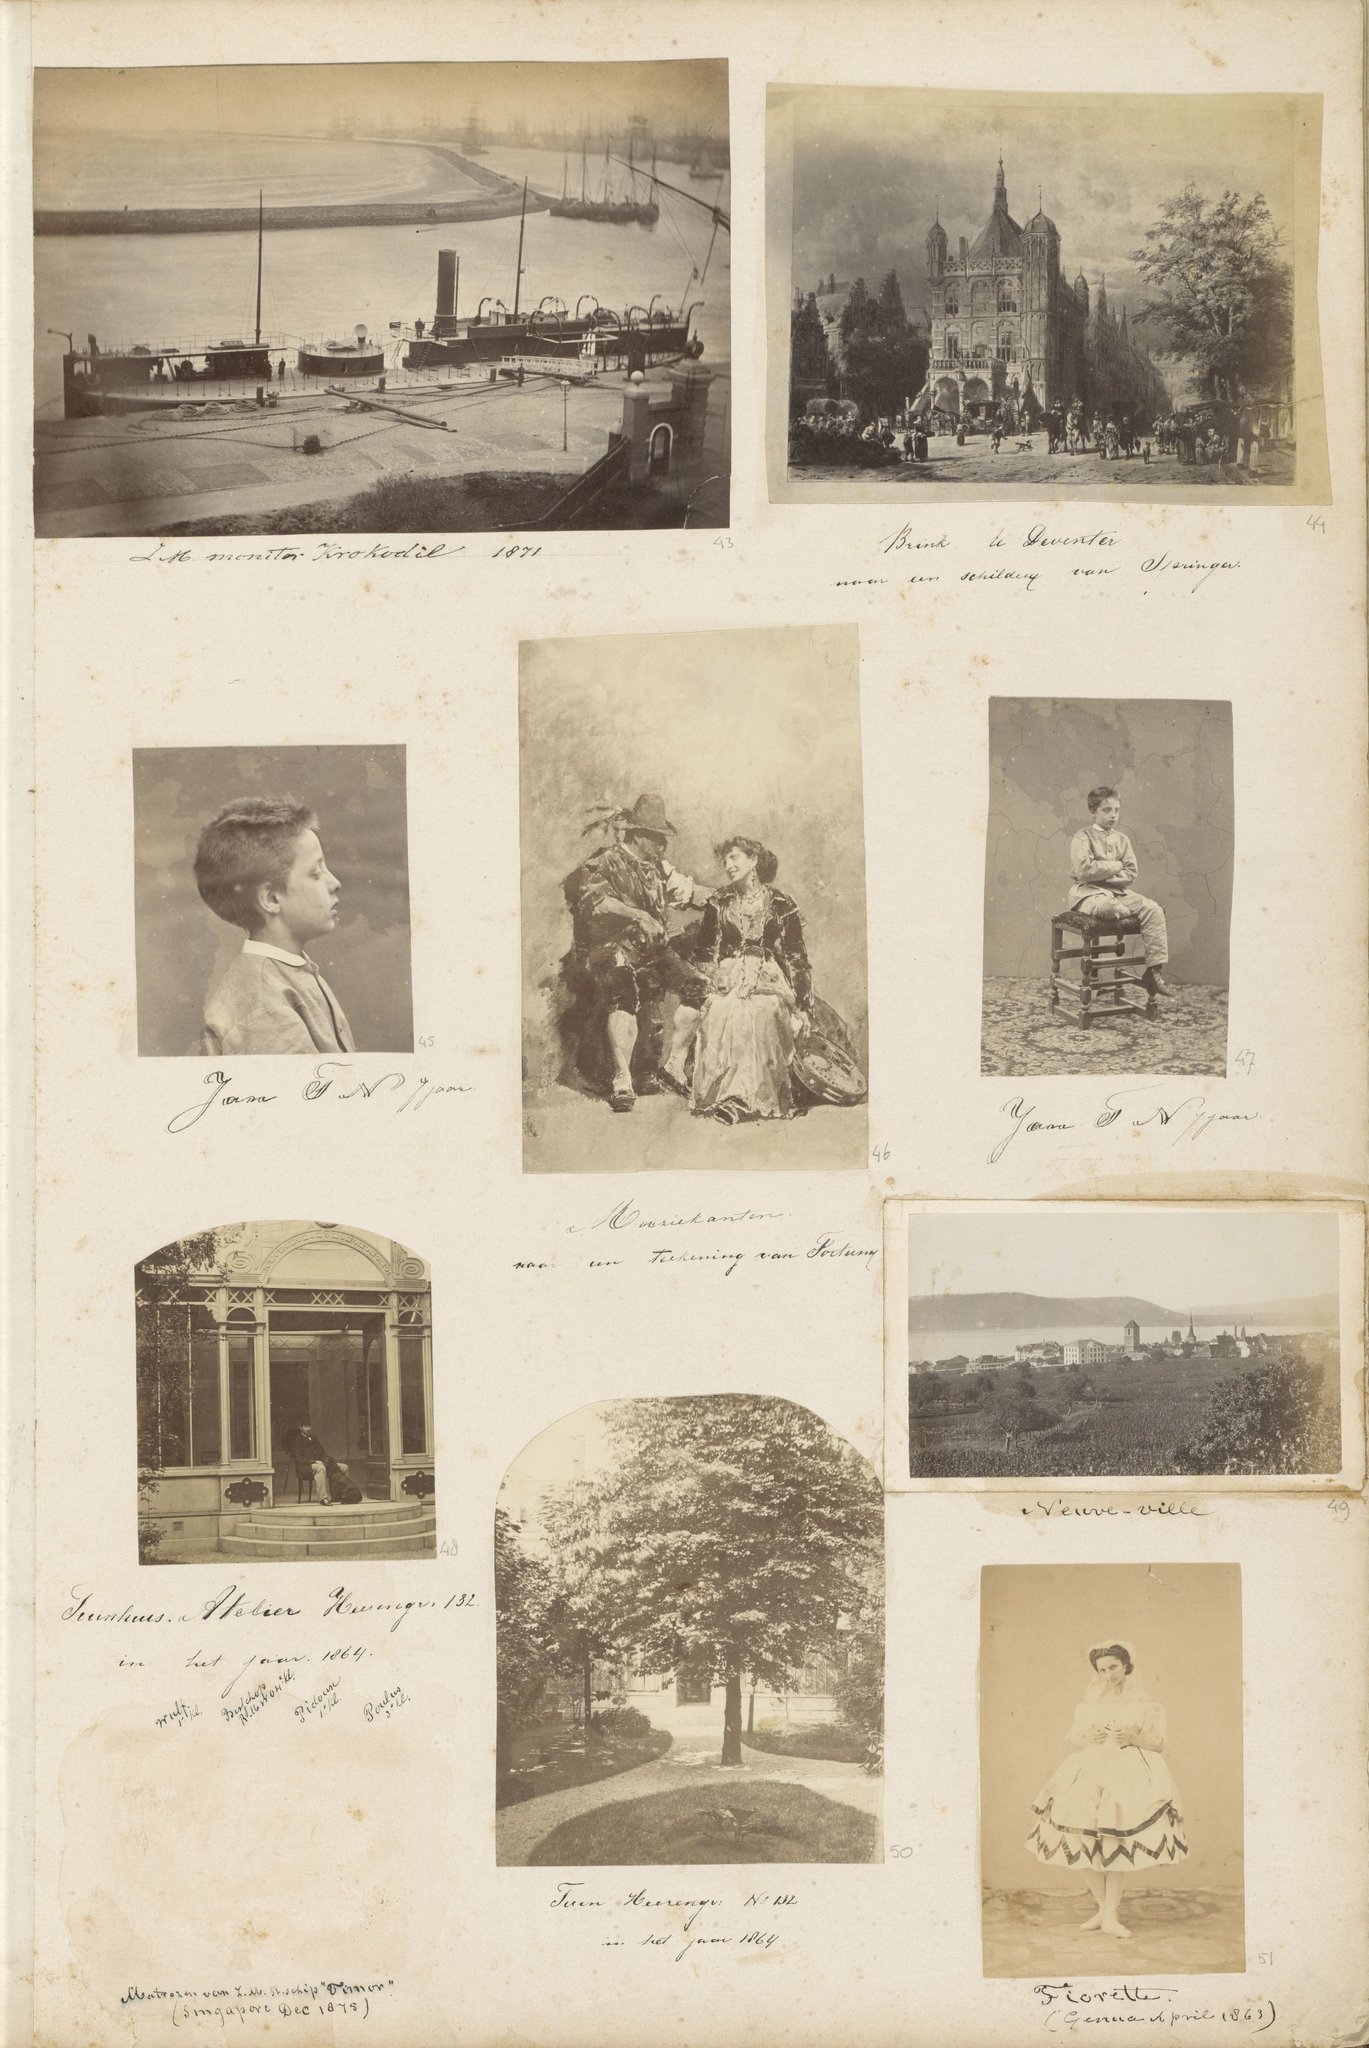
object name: album leaf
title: Claude August Crommelin (1840-1874) met hond zittend voor een tuinhuis met fotoatelier achter Herengracht 132 te Amsterdam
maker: Anonymous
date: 1864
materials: paper, photographic support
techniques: albumen print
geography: amsterdam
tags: amsterdam, claude august crommelin (1840-1874), studio ~ photographer, tripod, adult man, summer-house, arbour, garden-house (dutch: 'theekoepel')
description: Onderdeel van Fotoalbum van Robert Daniel Crommelin (1841-1907).